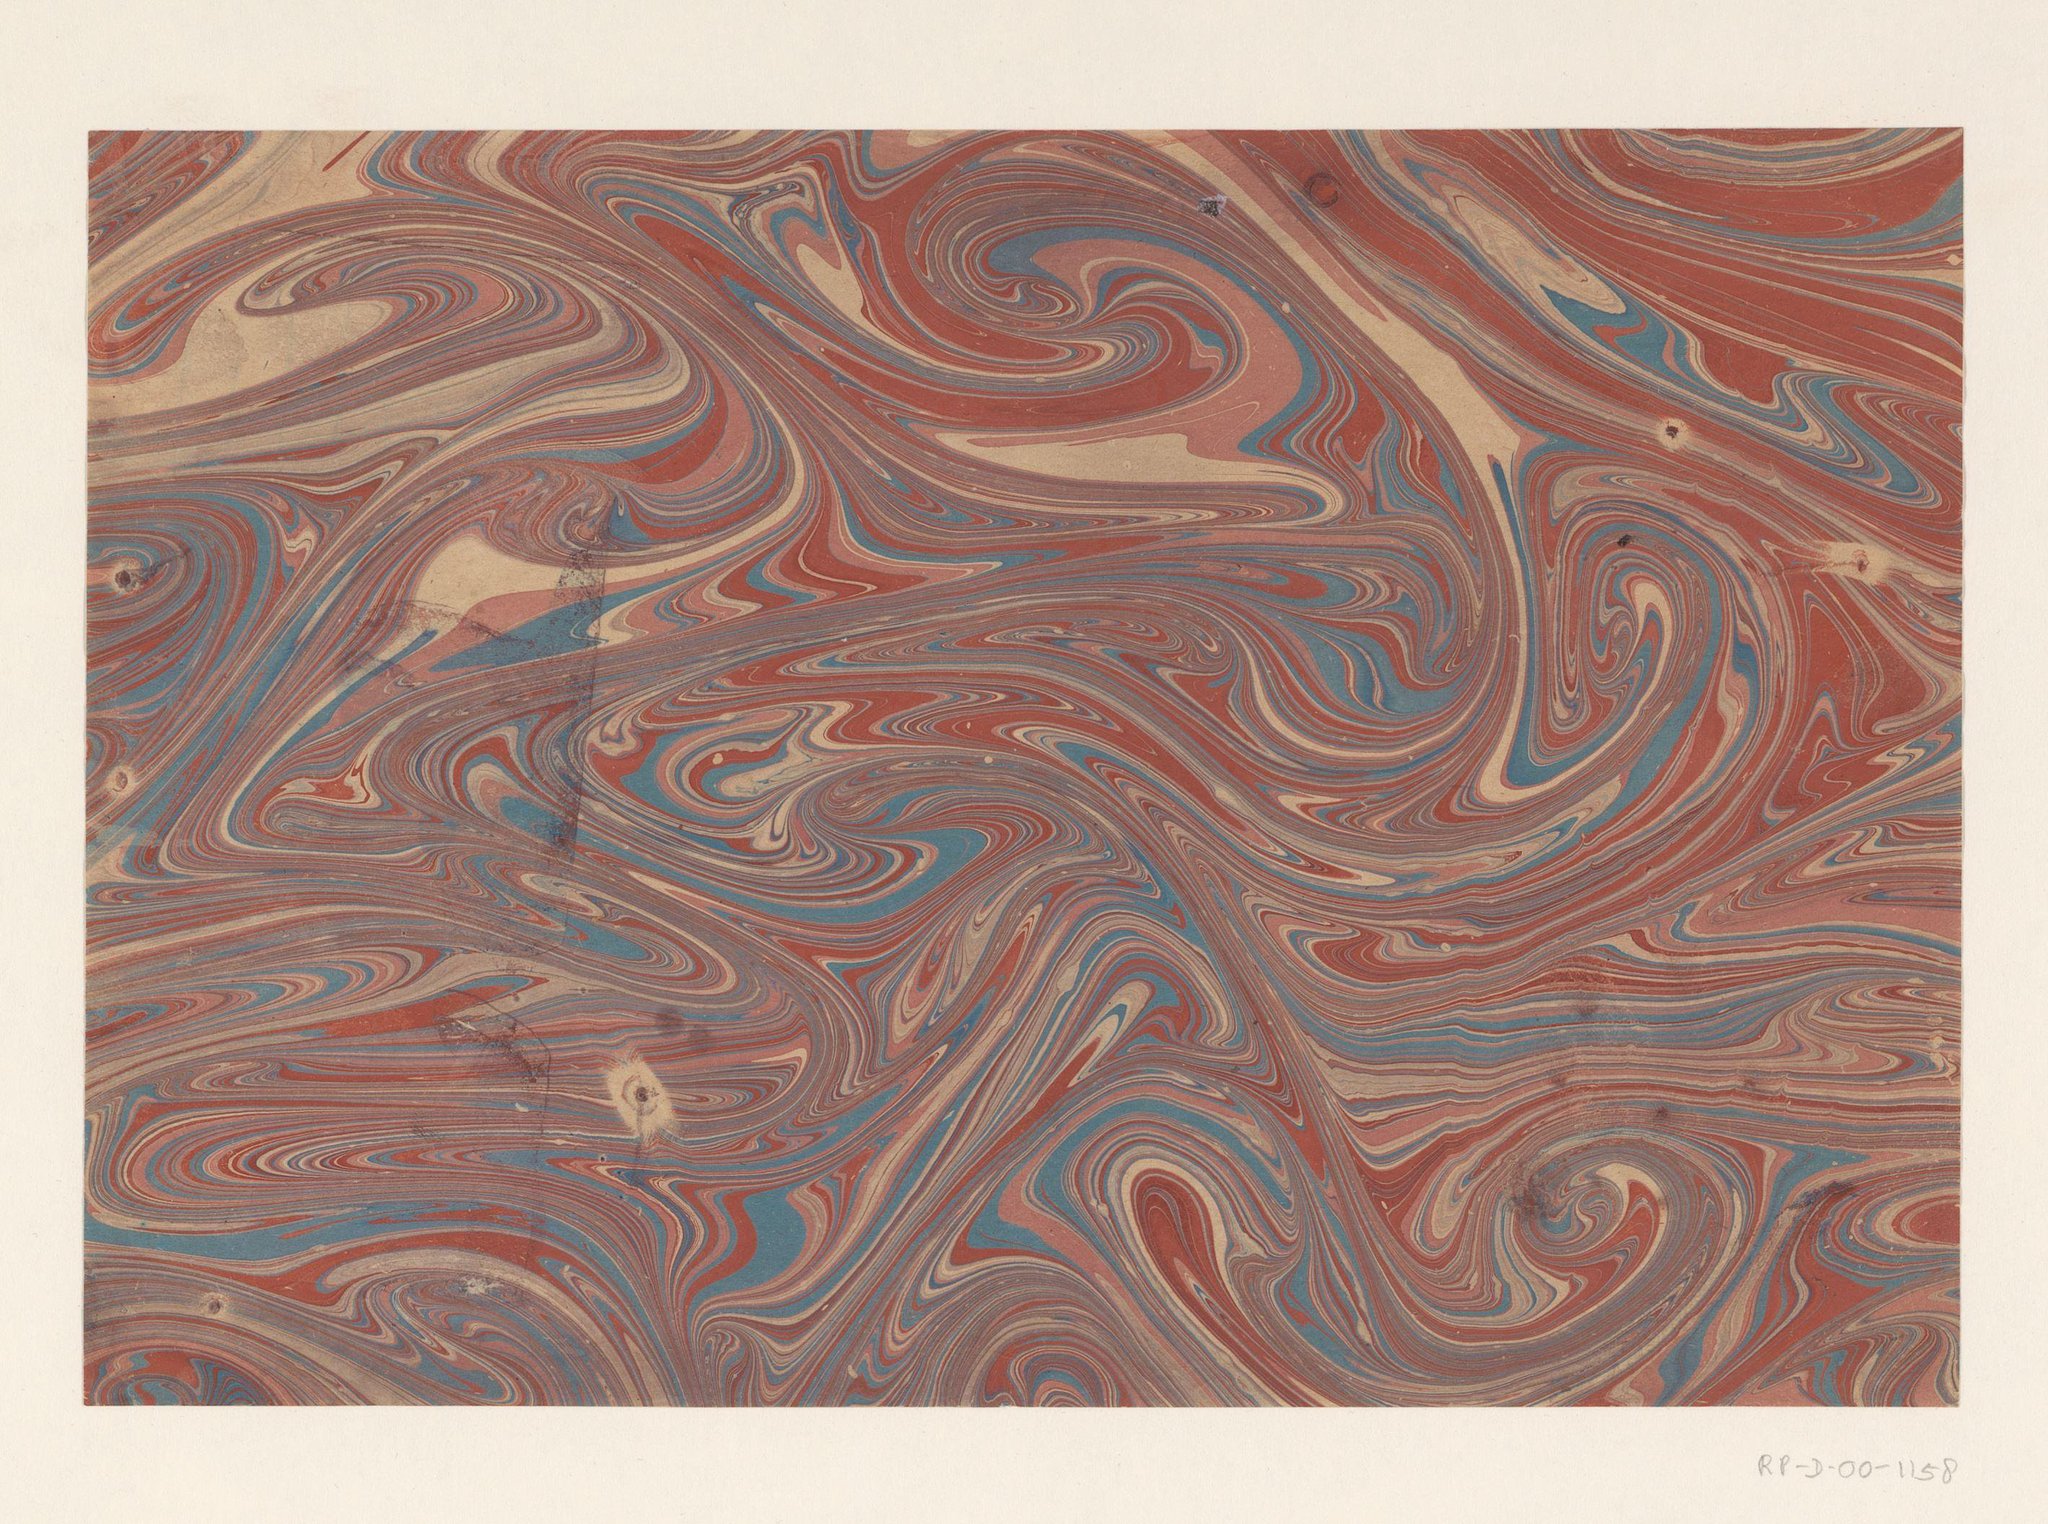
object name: marbled paper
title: Fantasie- of lussenmarmer in blauw, rood en roze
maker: Anonymous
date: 1800-1950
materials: paint, paper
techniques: marbled paper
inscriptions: collector's mark: Lugt 2228